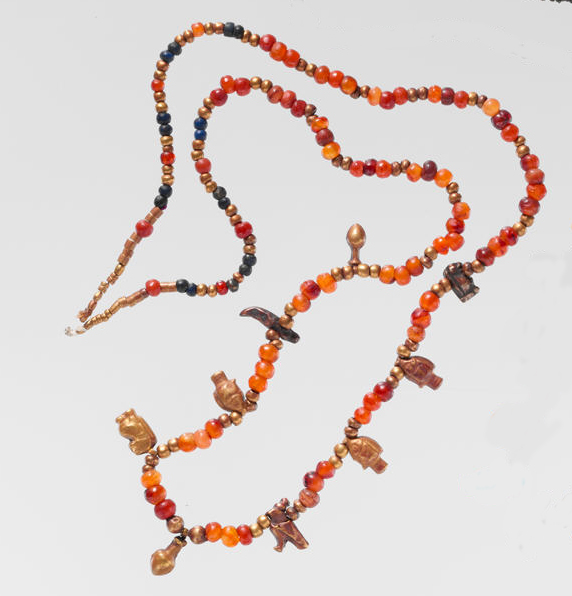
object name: necklace, bead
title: Necklace of ball beads and gold amulets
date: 1550-1425 BCE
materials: gemstone, gold, lapis lazuli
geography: egypt